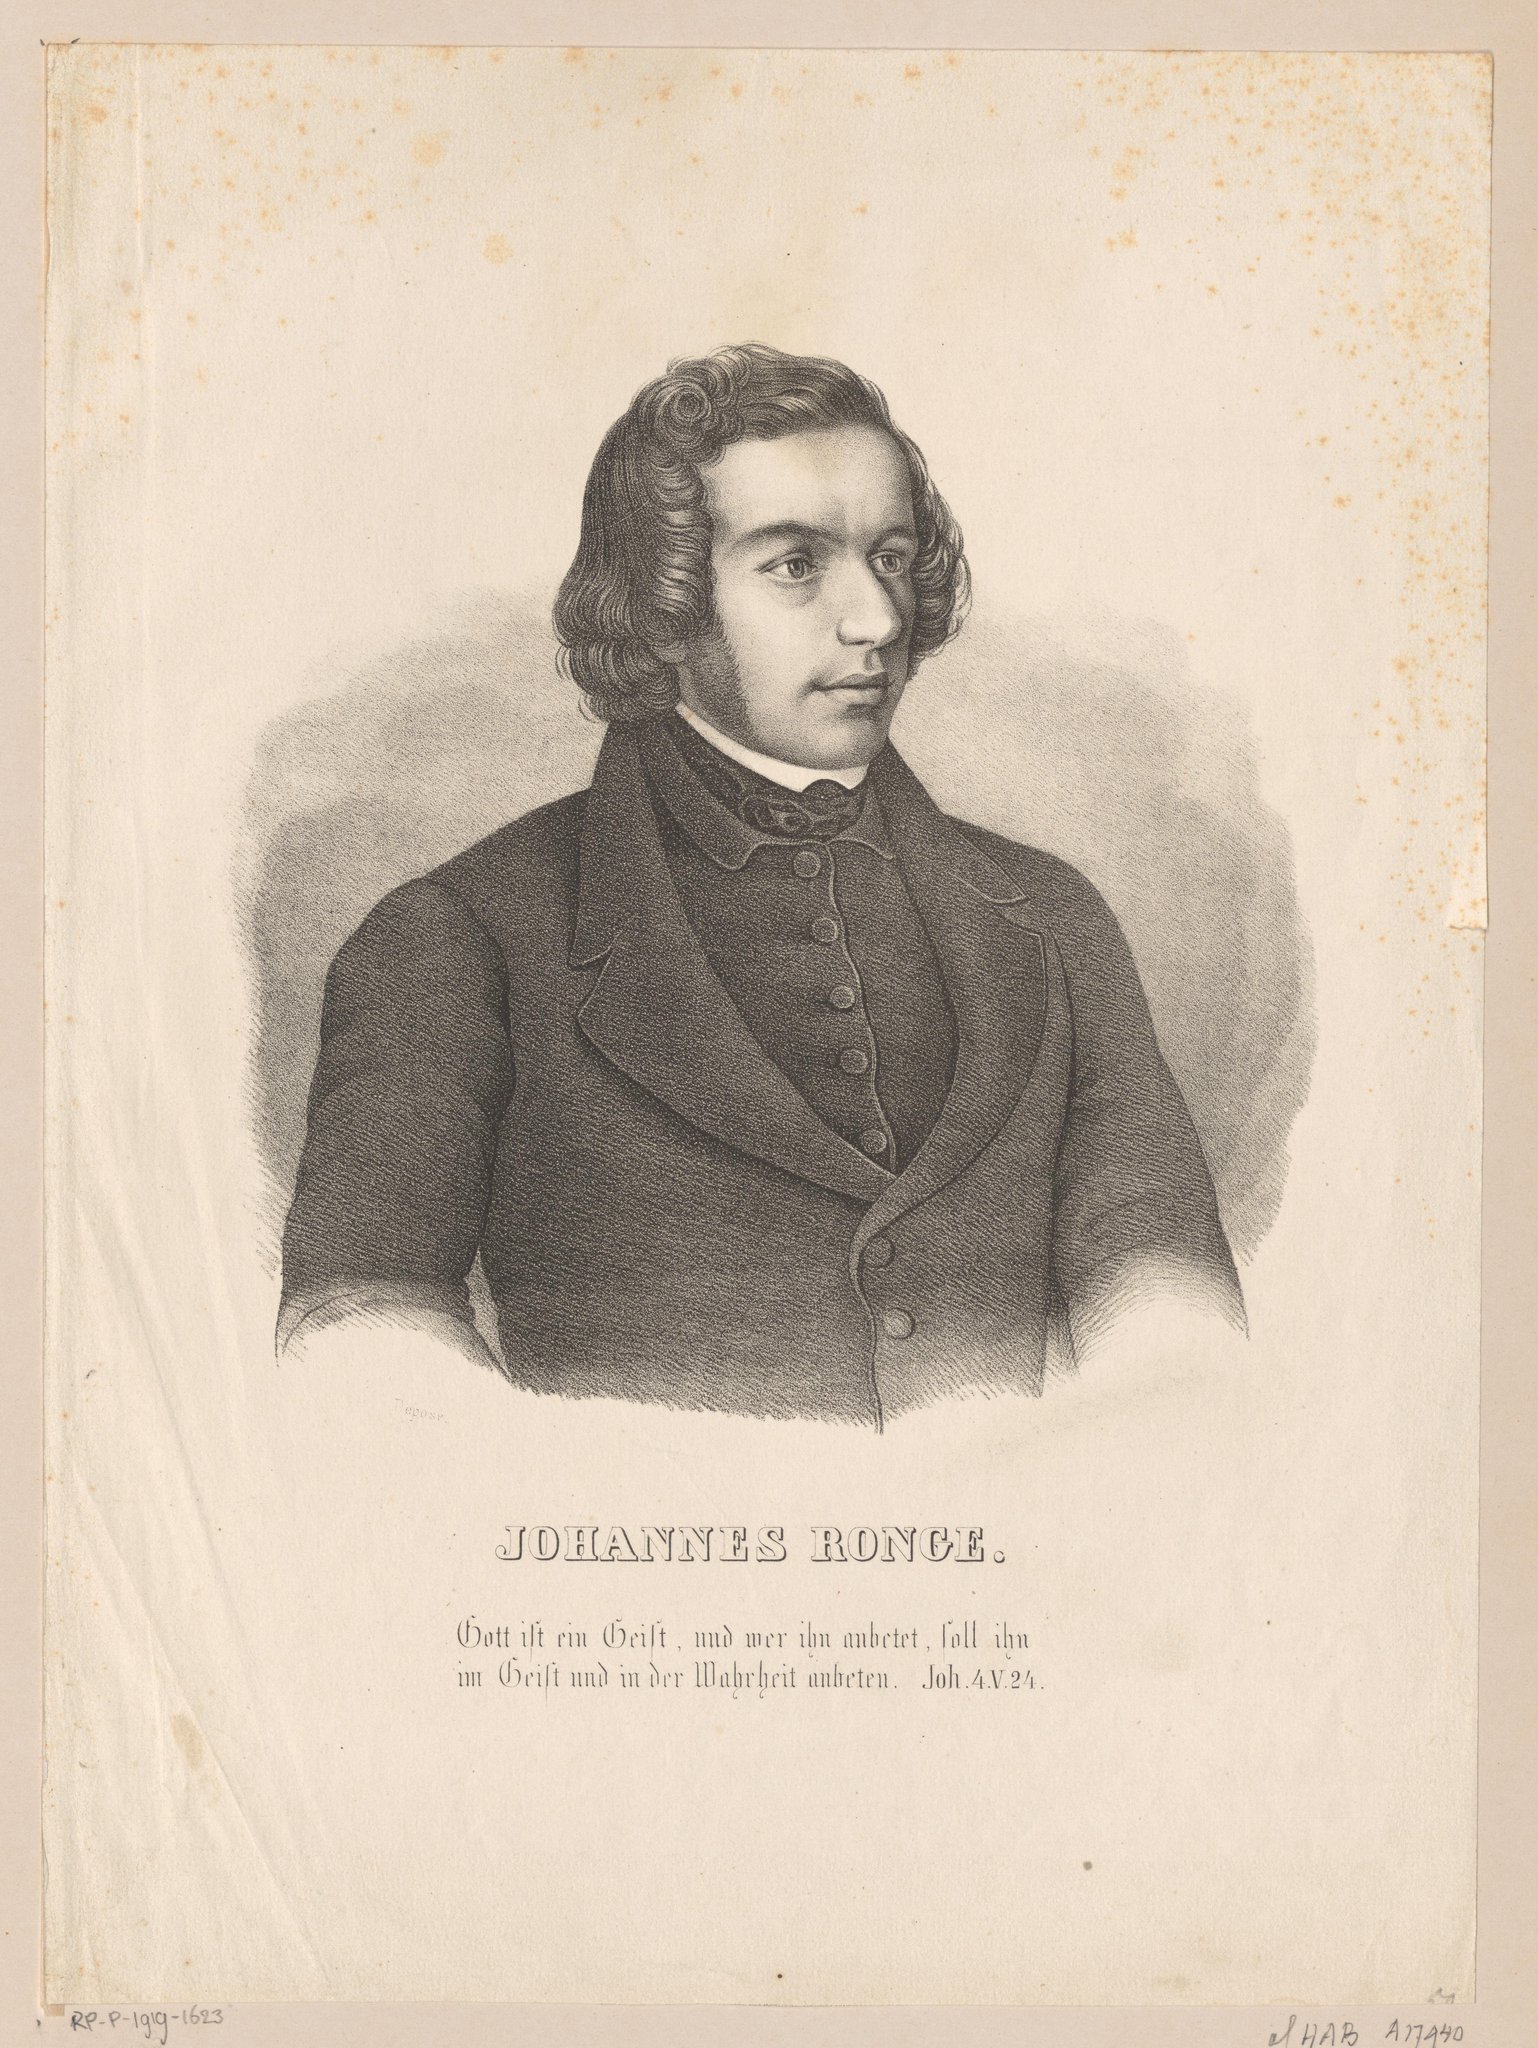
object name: print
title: Portret van Johannes Ronge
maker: Anonymous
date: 1833-1899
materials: paper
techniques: lithograph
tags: theologian, historical persons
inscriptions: collector's mark: Lugt 2228